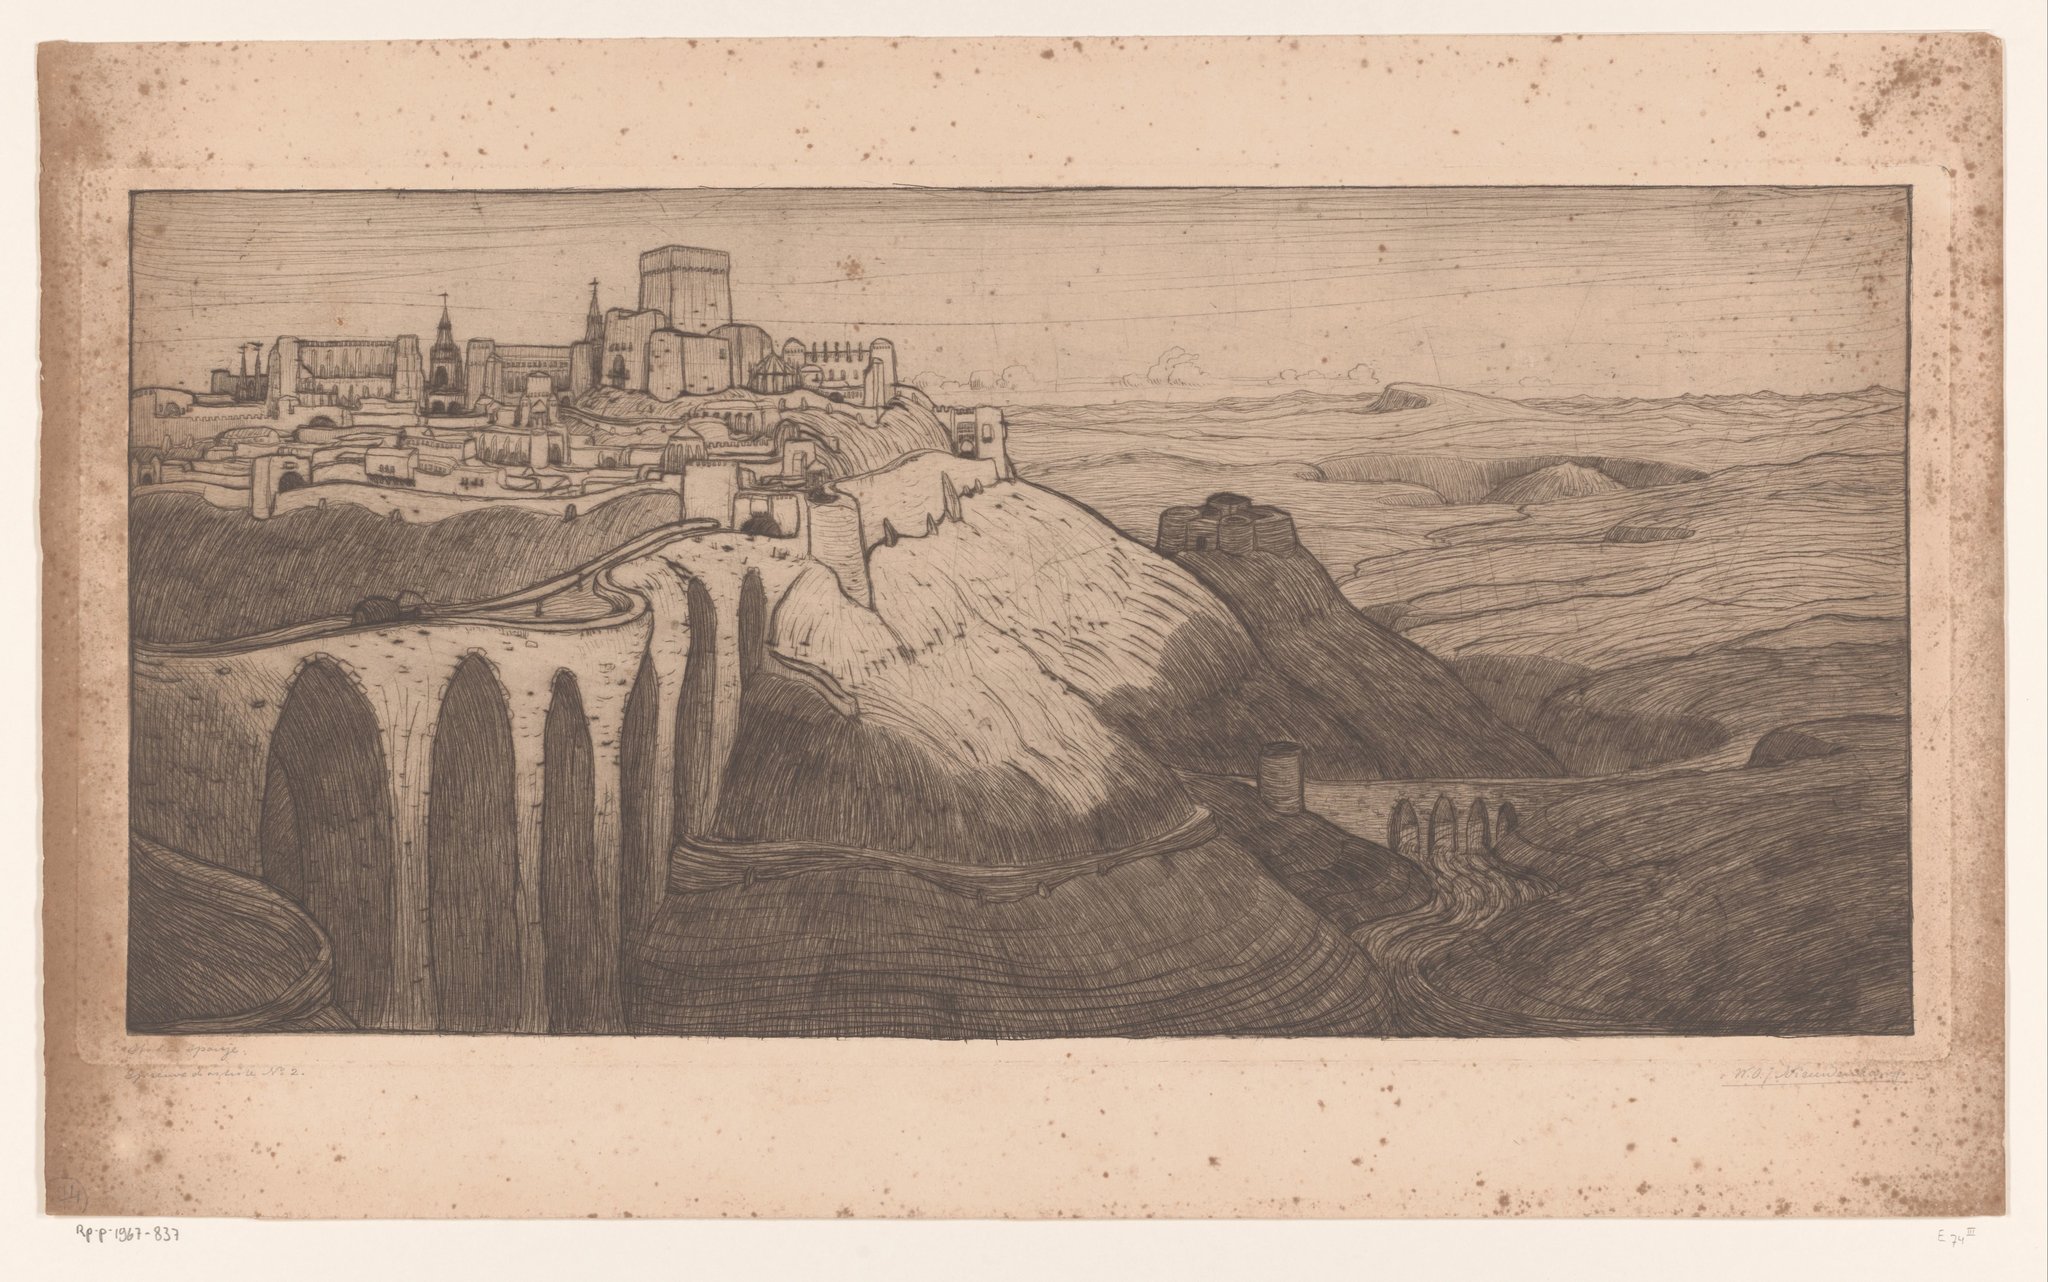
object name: print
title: Stad in Spanje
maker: wijnand otto jan nieuwenkamp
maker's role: draughtsman, print maker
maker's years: 1874-1950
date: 1903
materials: paper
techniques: drypoint, intaglio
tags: prospect of city, town panorama, silhouette of city, spain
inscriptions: collector's mark: Lugt 2760, collector's mark: Lugt 2228